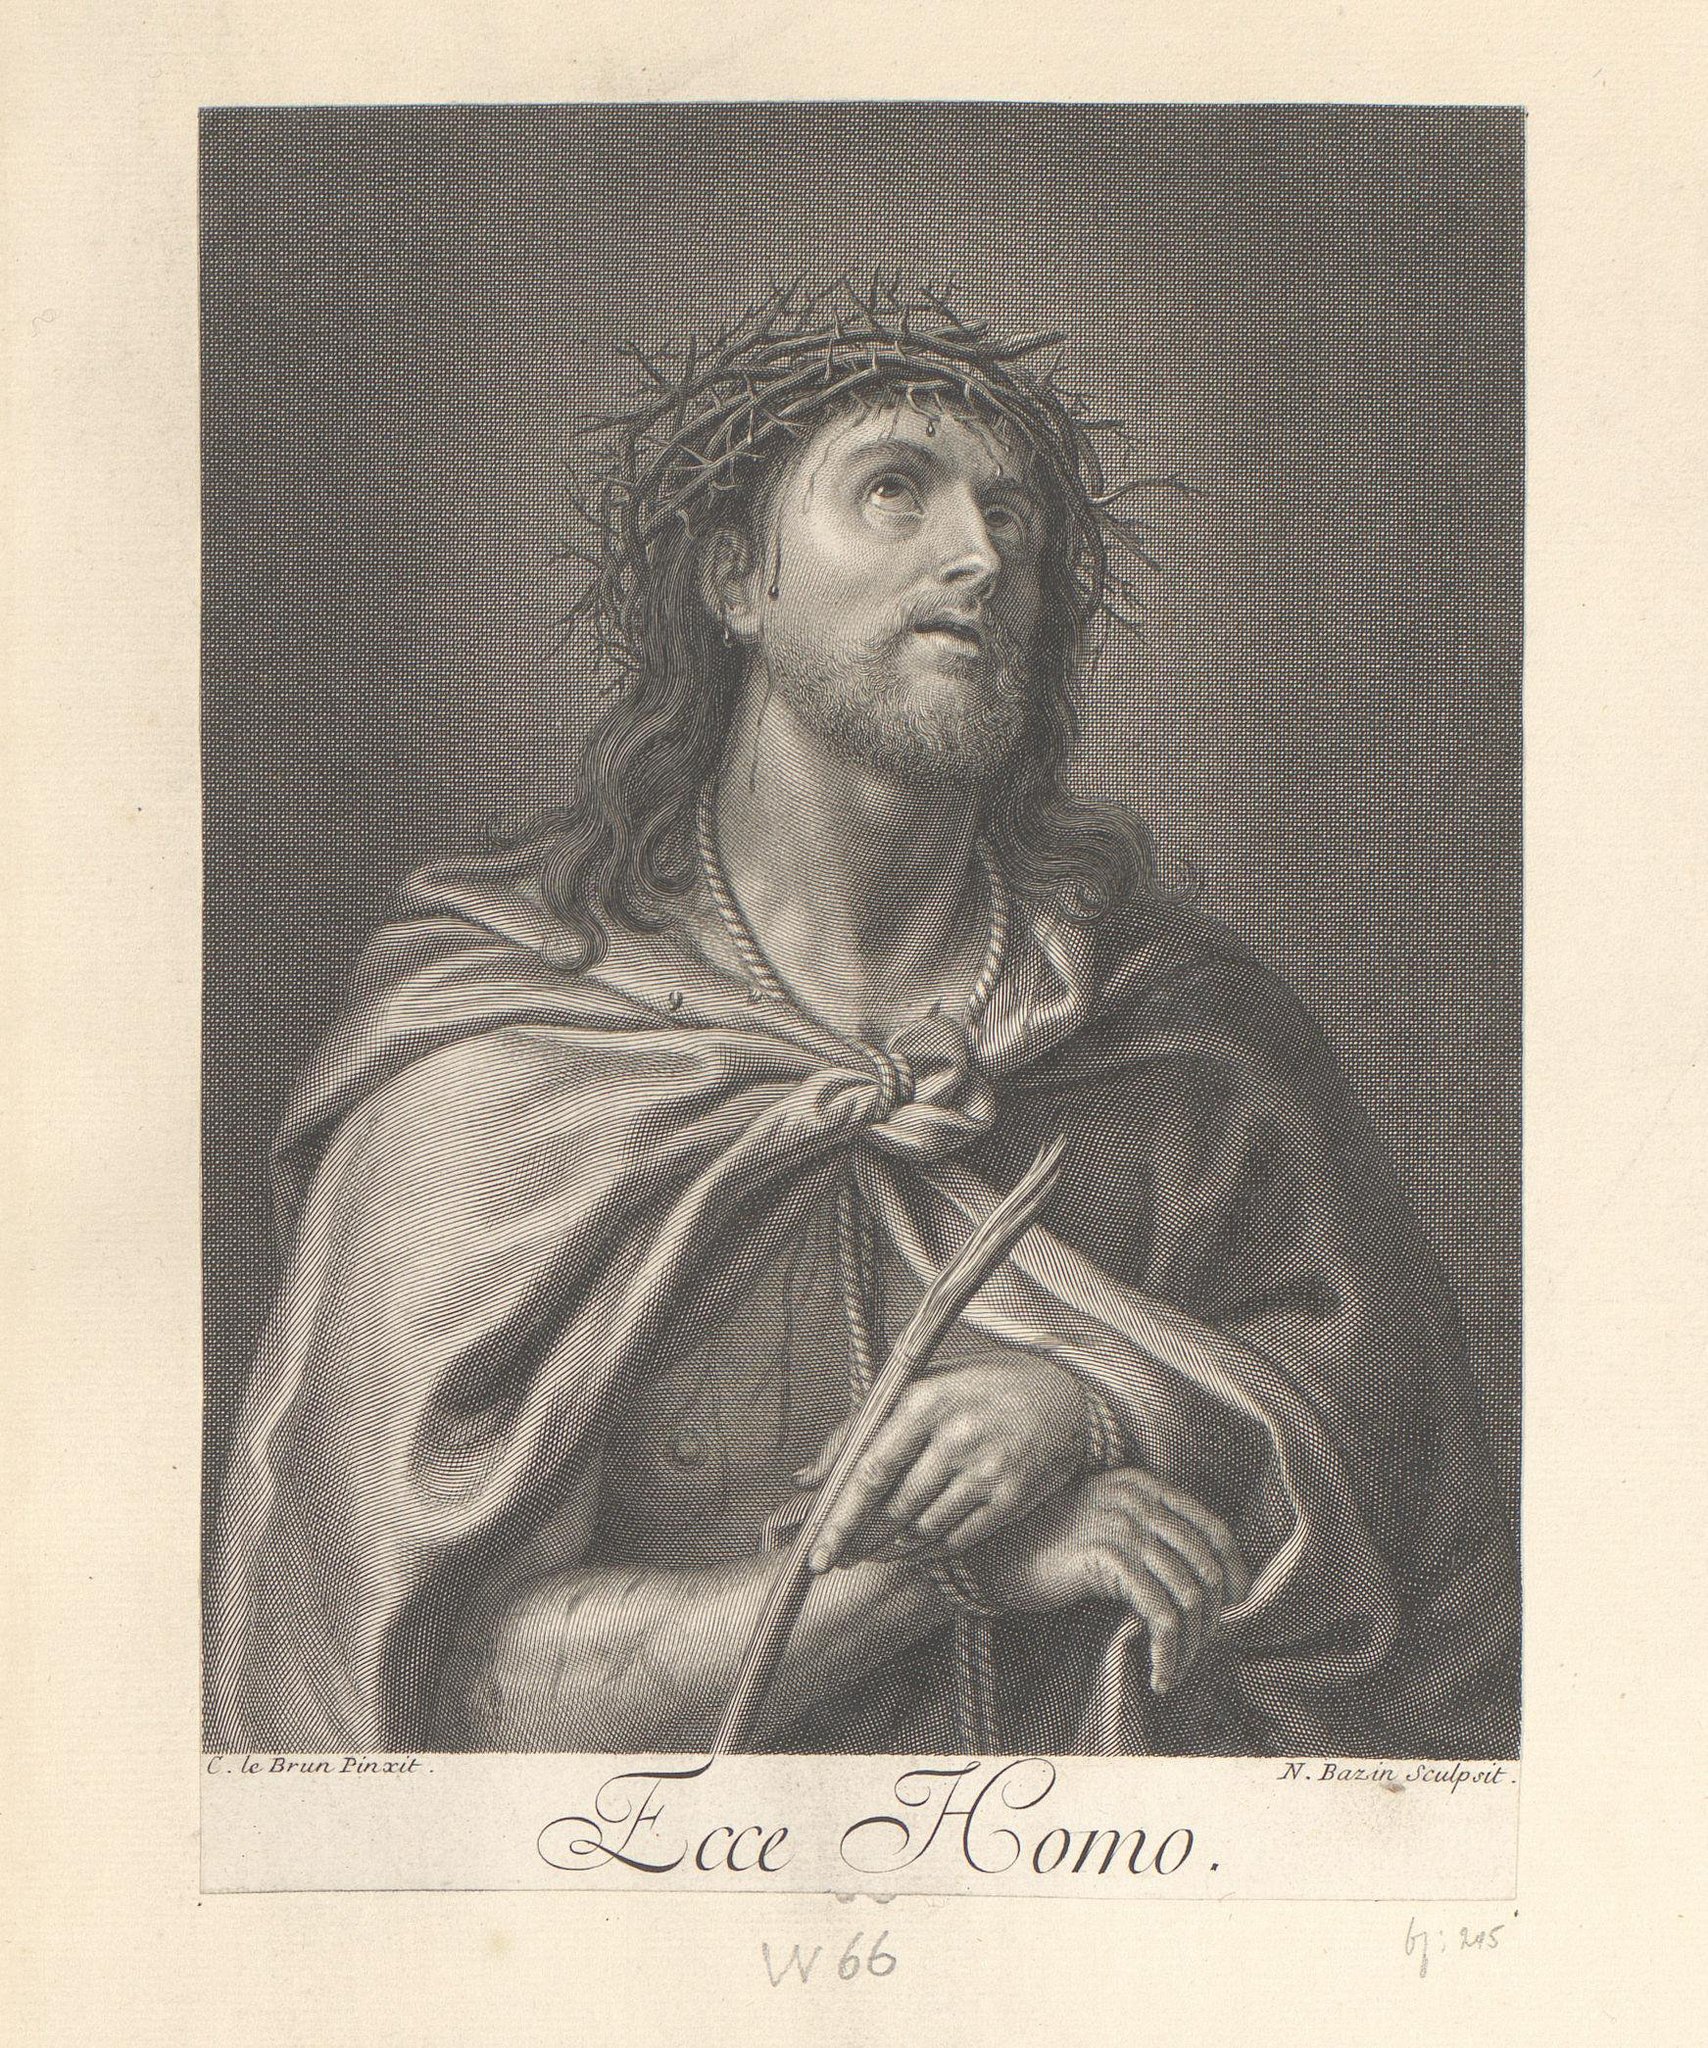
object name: album leaf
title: Ecce Homo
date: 1643-1710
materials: paper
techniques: engraving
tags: christ alone (also called 'ecce homo')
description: Deze prent maakt deel uit van een album.